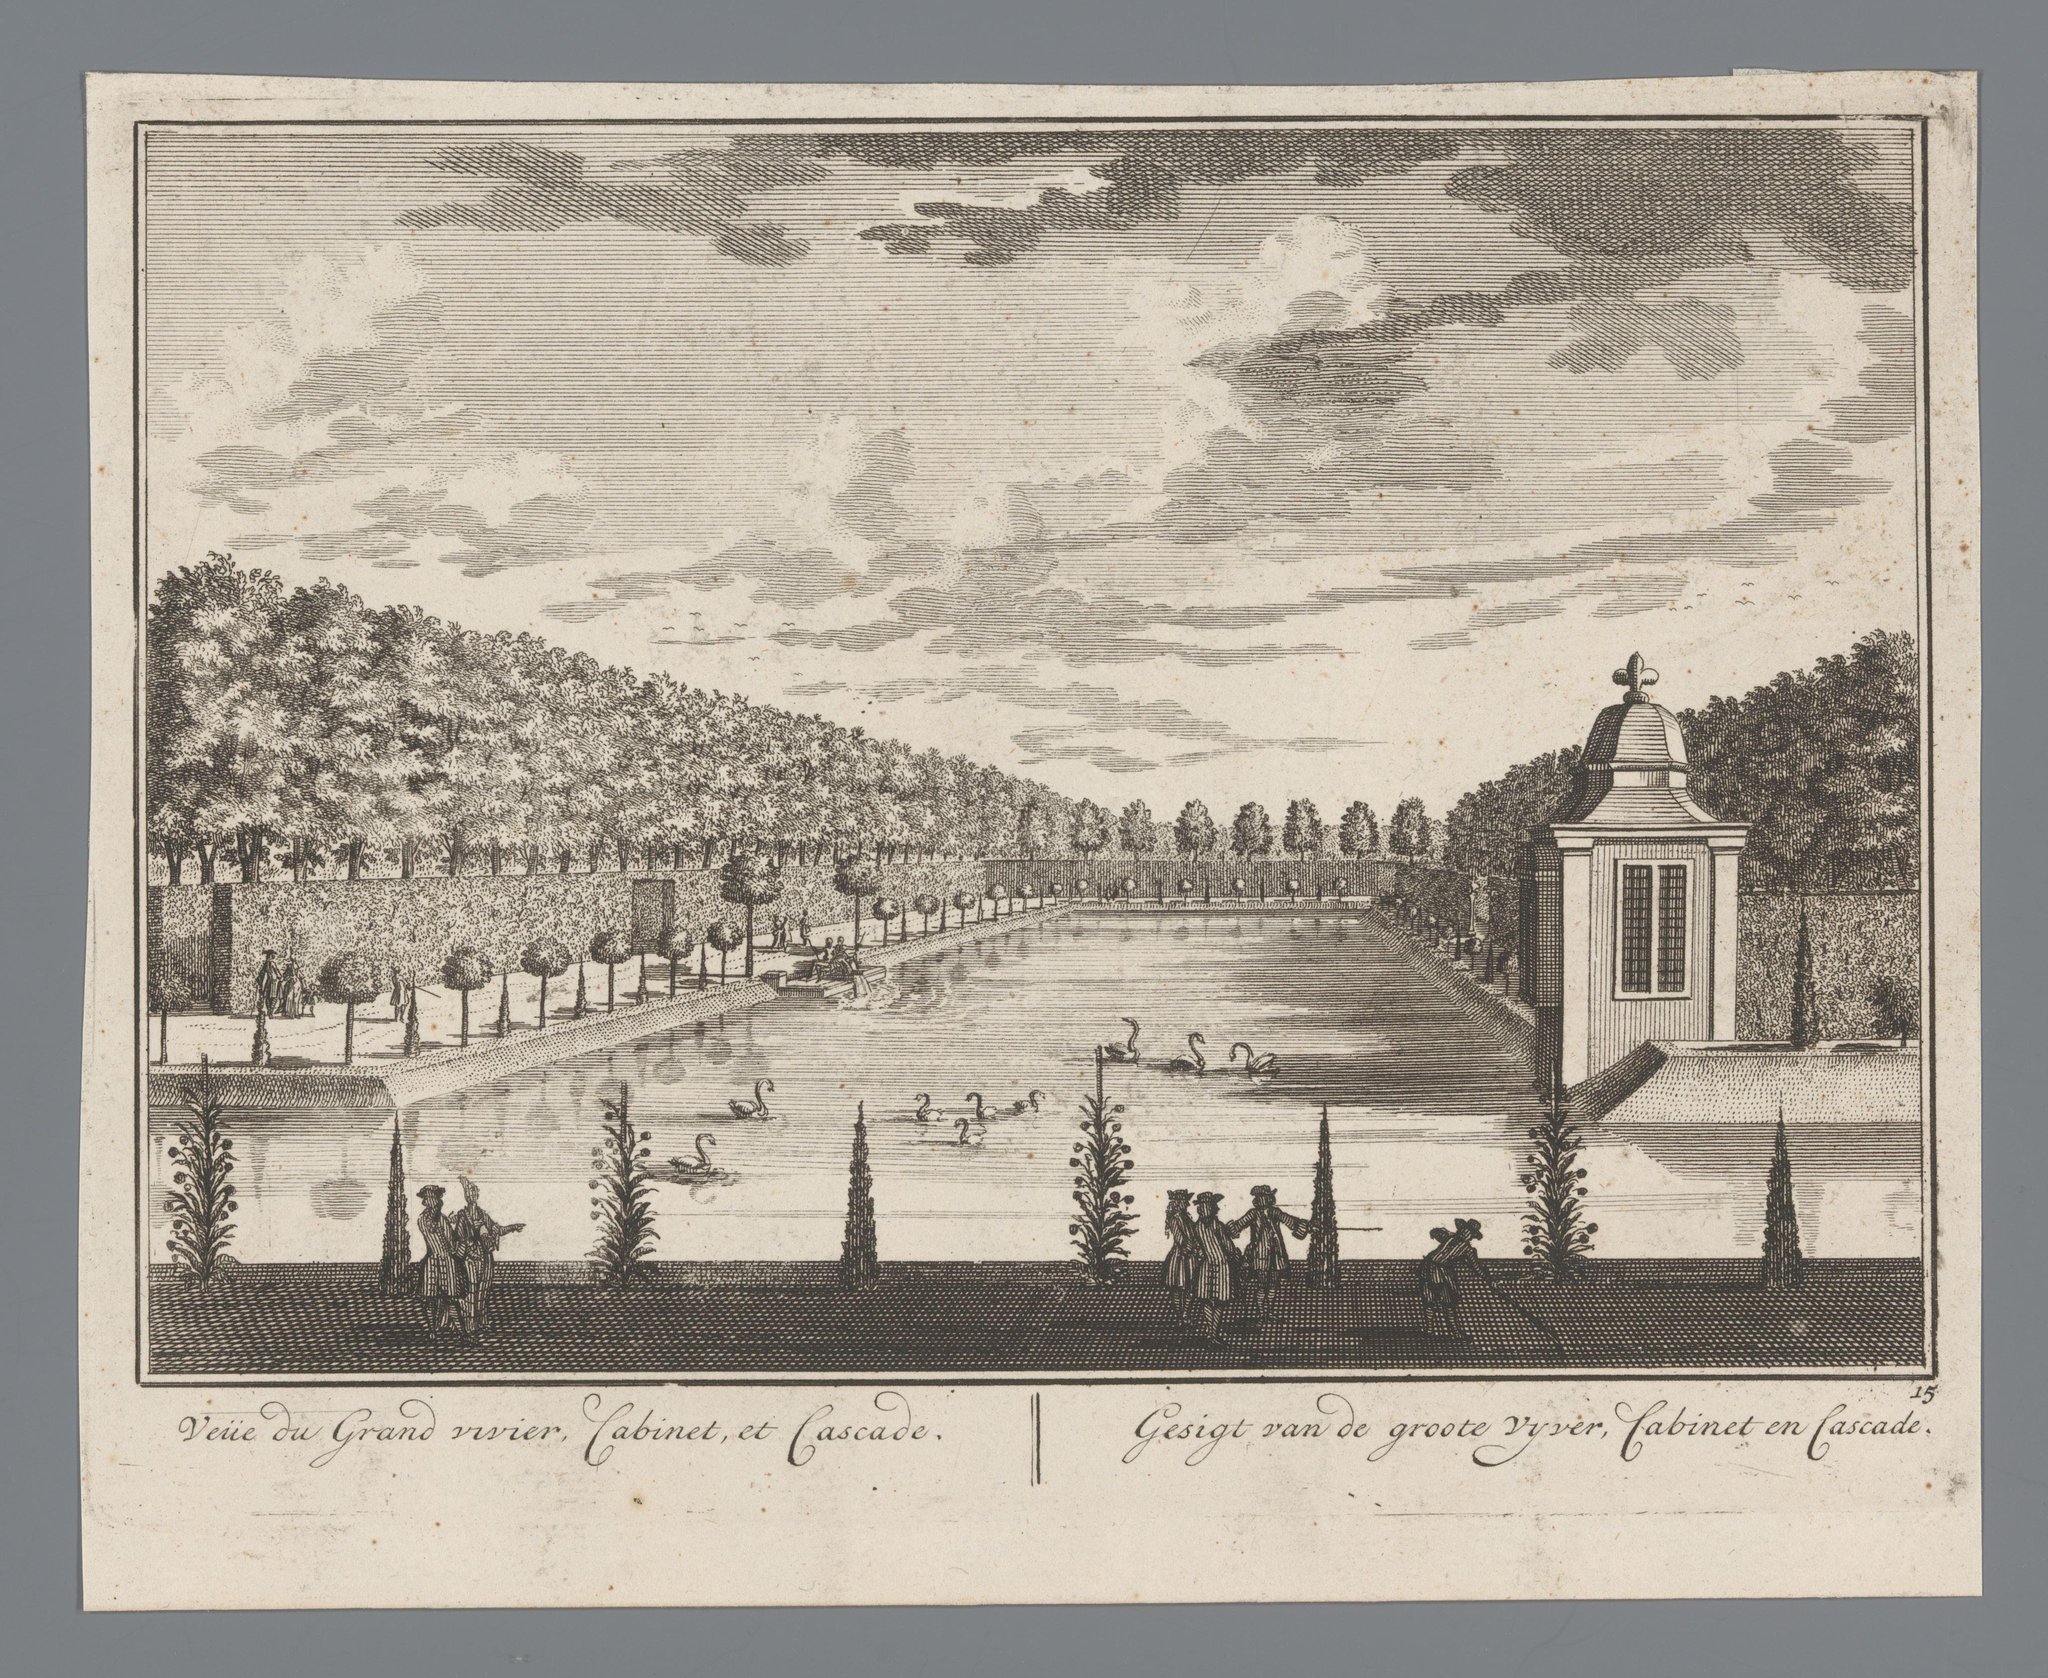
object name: print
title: Gezicht op de grote vijver in de tuin van Slot Zeist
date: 1682-1726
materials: paper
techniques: etching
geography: amsterdam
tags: castle, landscape with tower or castle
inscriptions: collector's mark: Lugt 2233